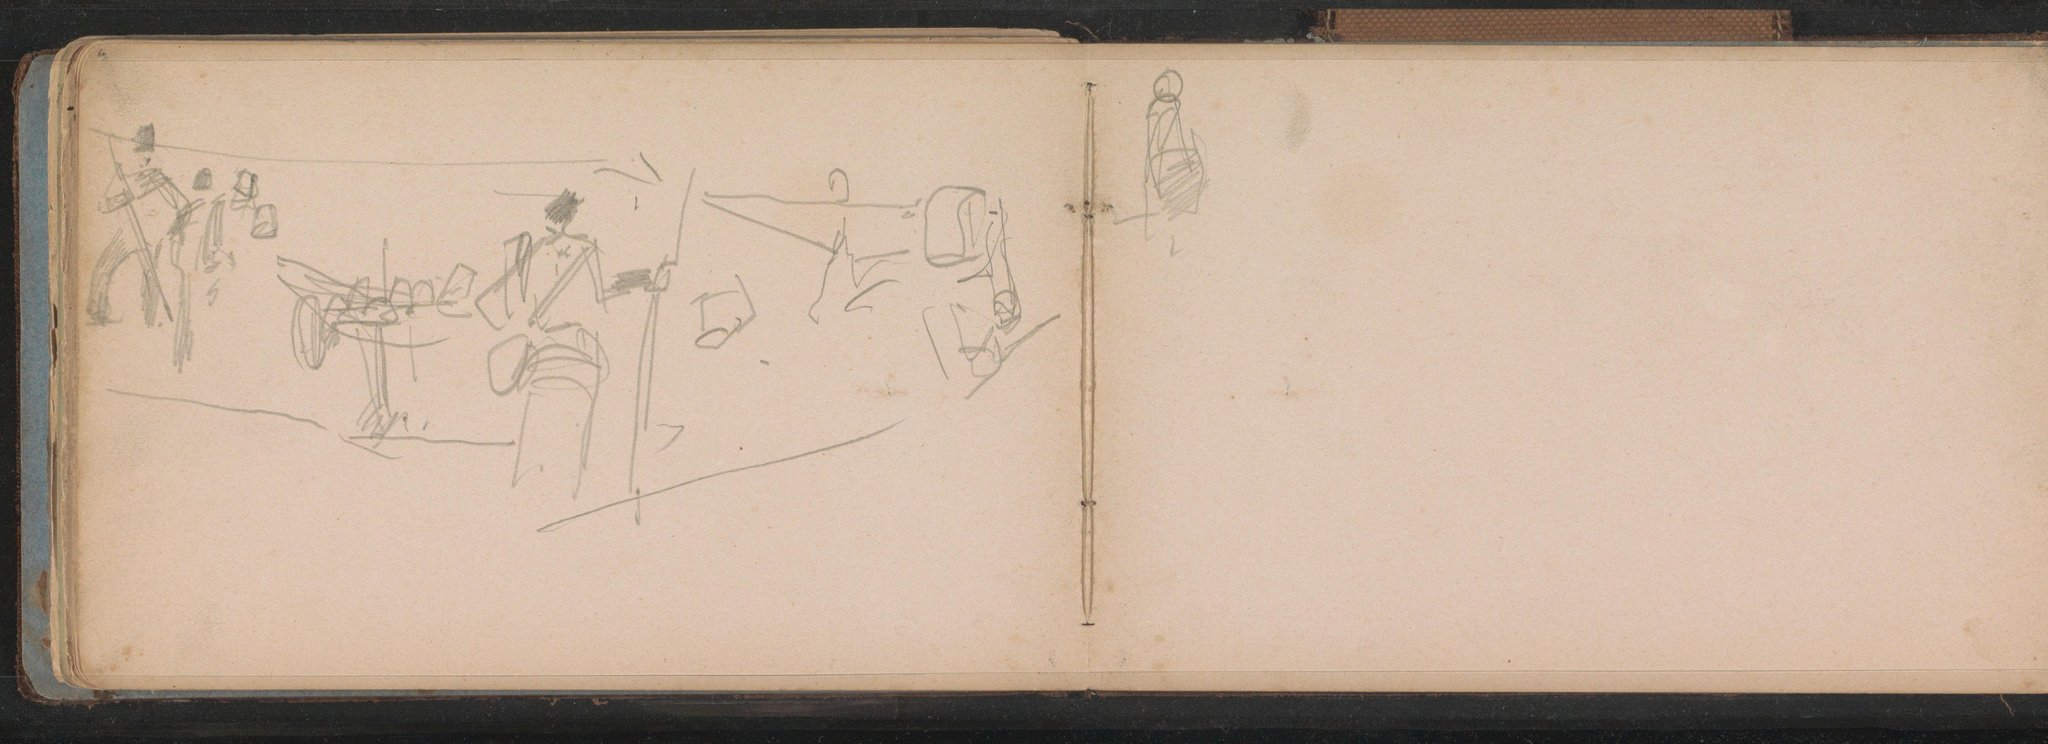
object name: sketchbook leaf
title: Figuurstudies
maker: george hendrik breitner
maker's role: draughtsman, painter, print maker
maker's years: 1857-1923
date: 1880-1882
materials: paper, pencil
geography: scheveningen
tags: adult woman, adult man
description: Pagina 69 en pagina 70 uit een schetsboek met 37 bladen.